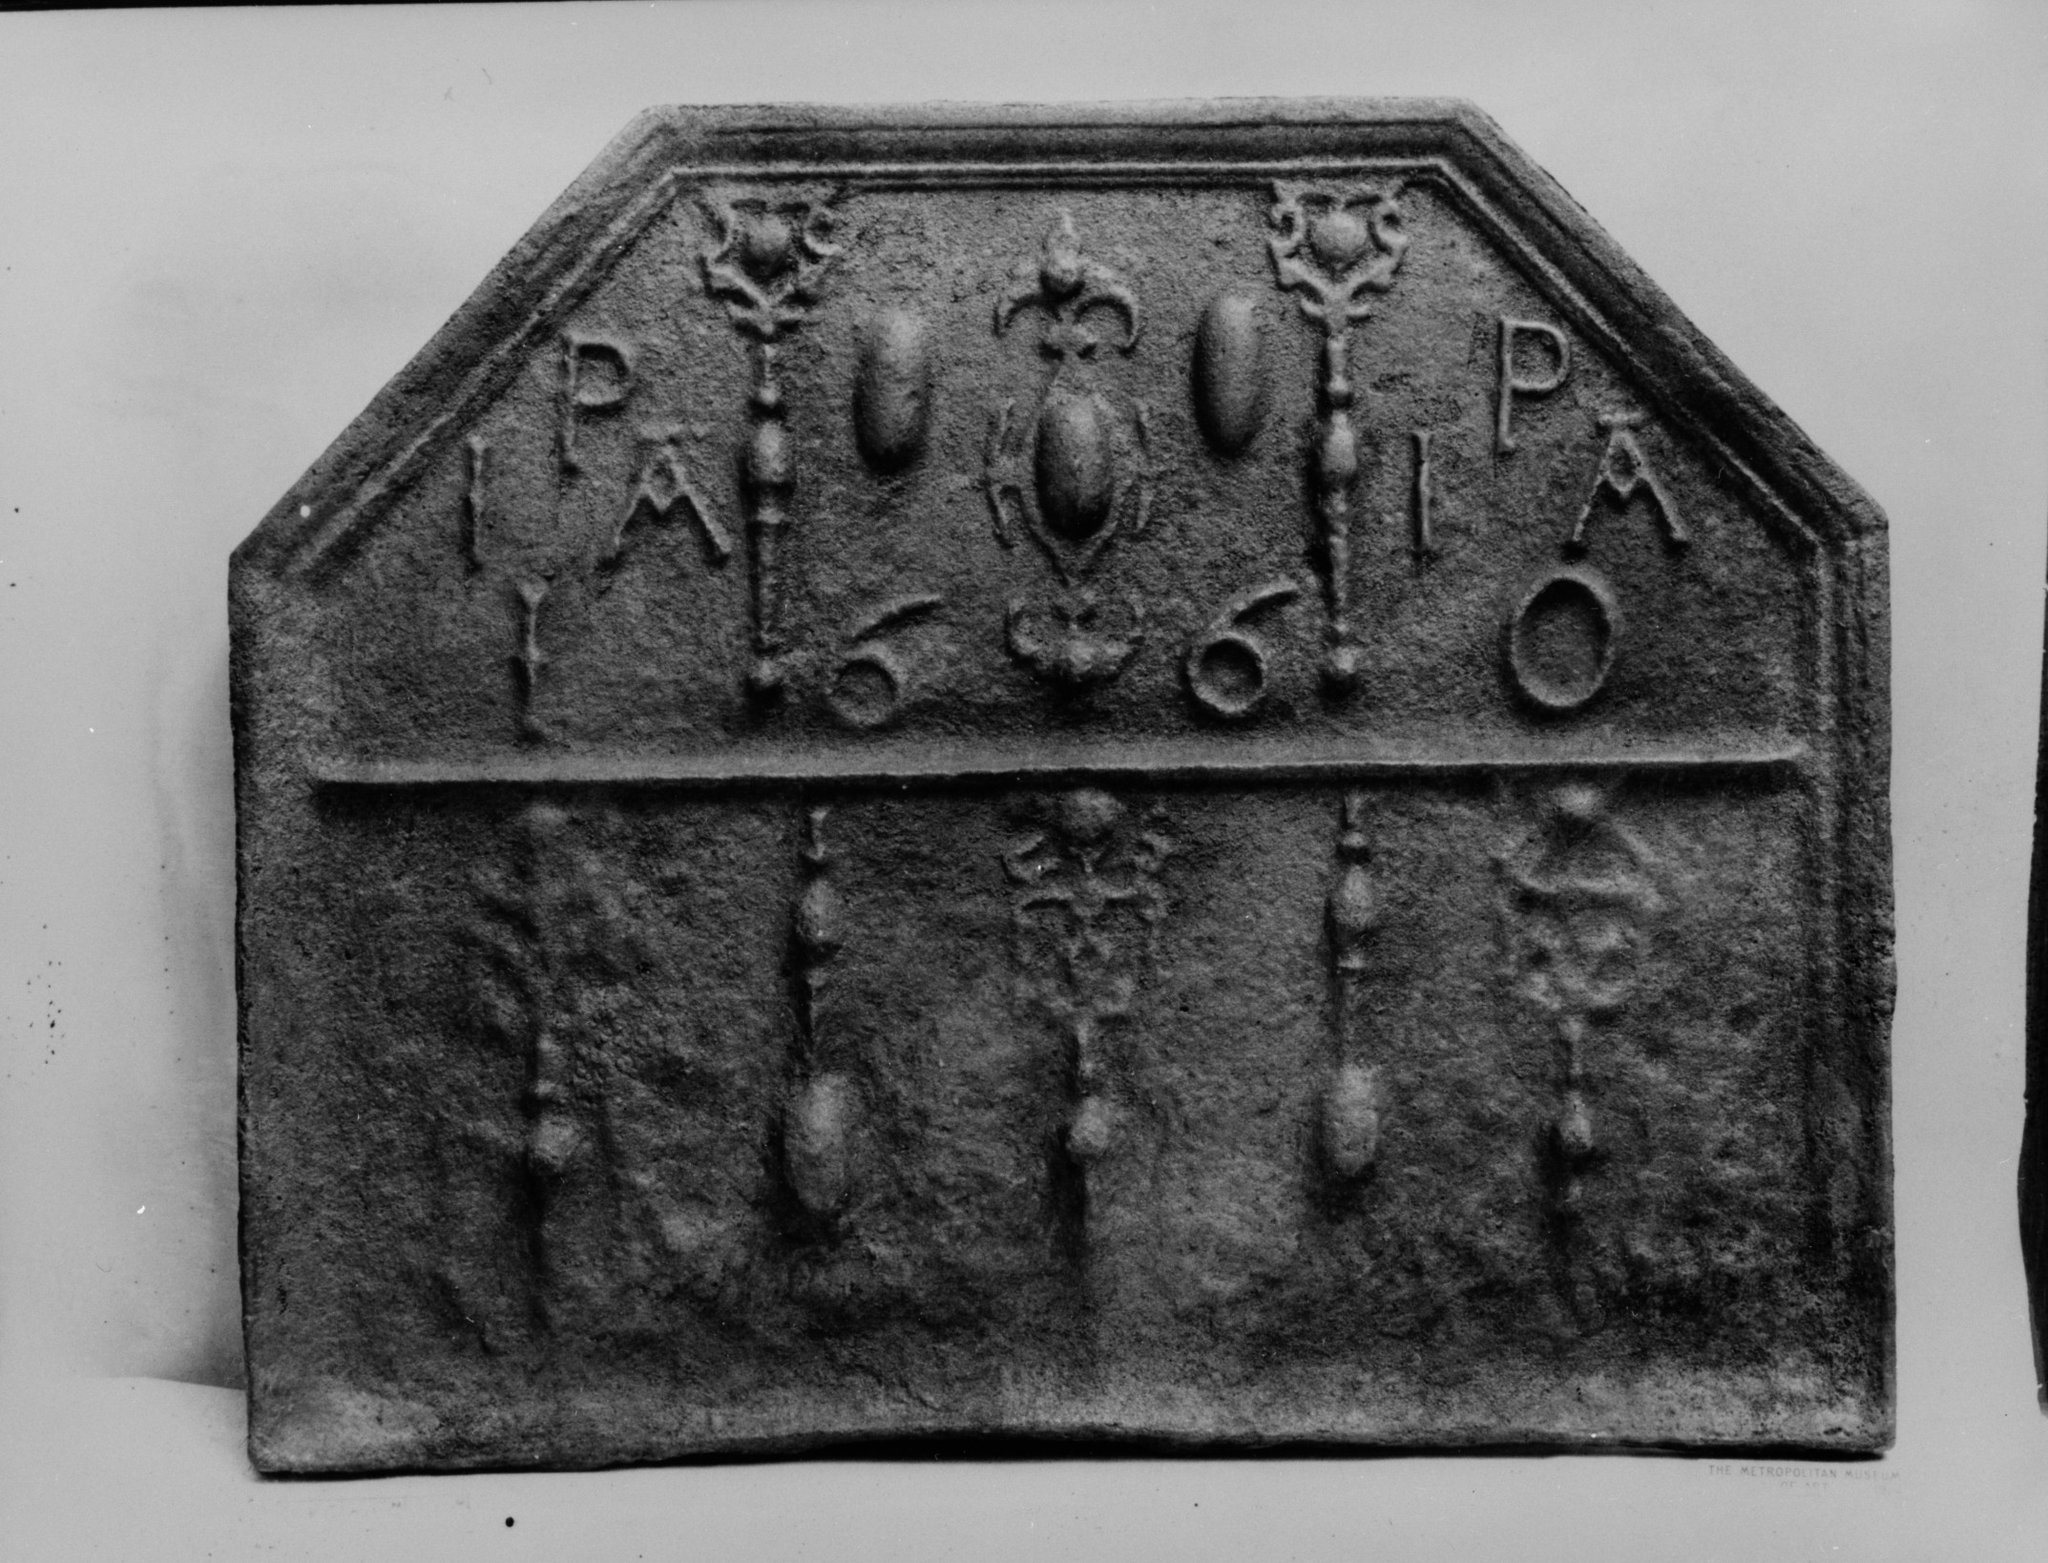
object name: fireback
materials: iron